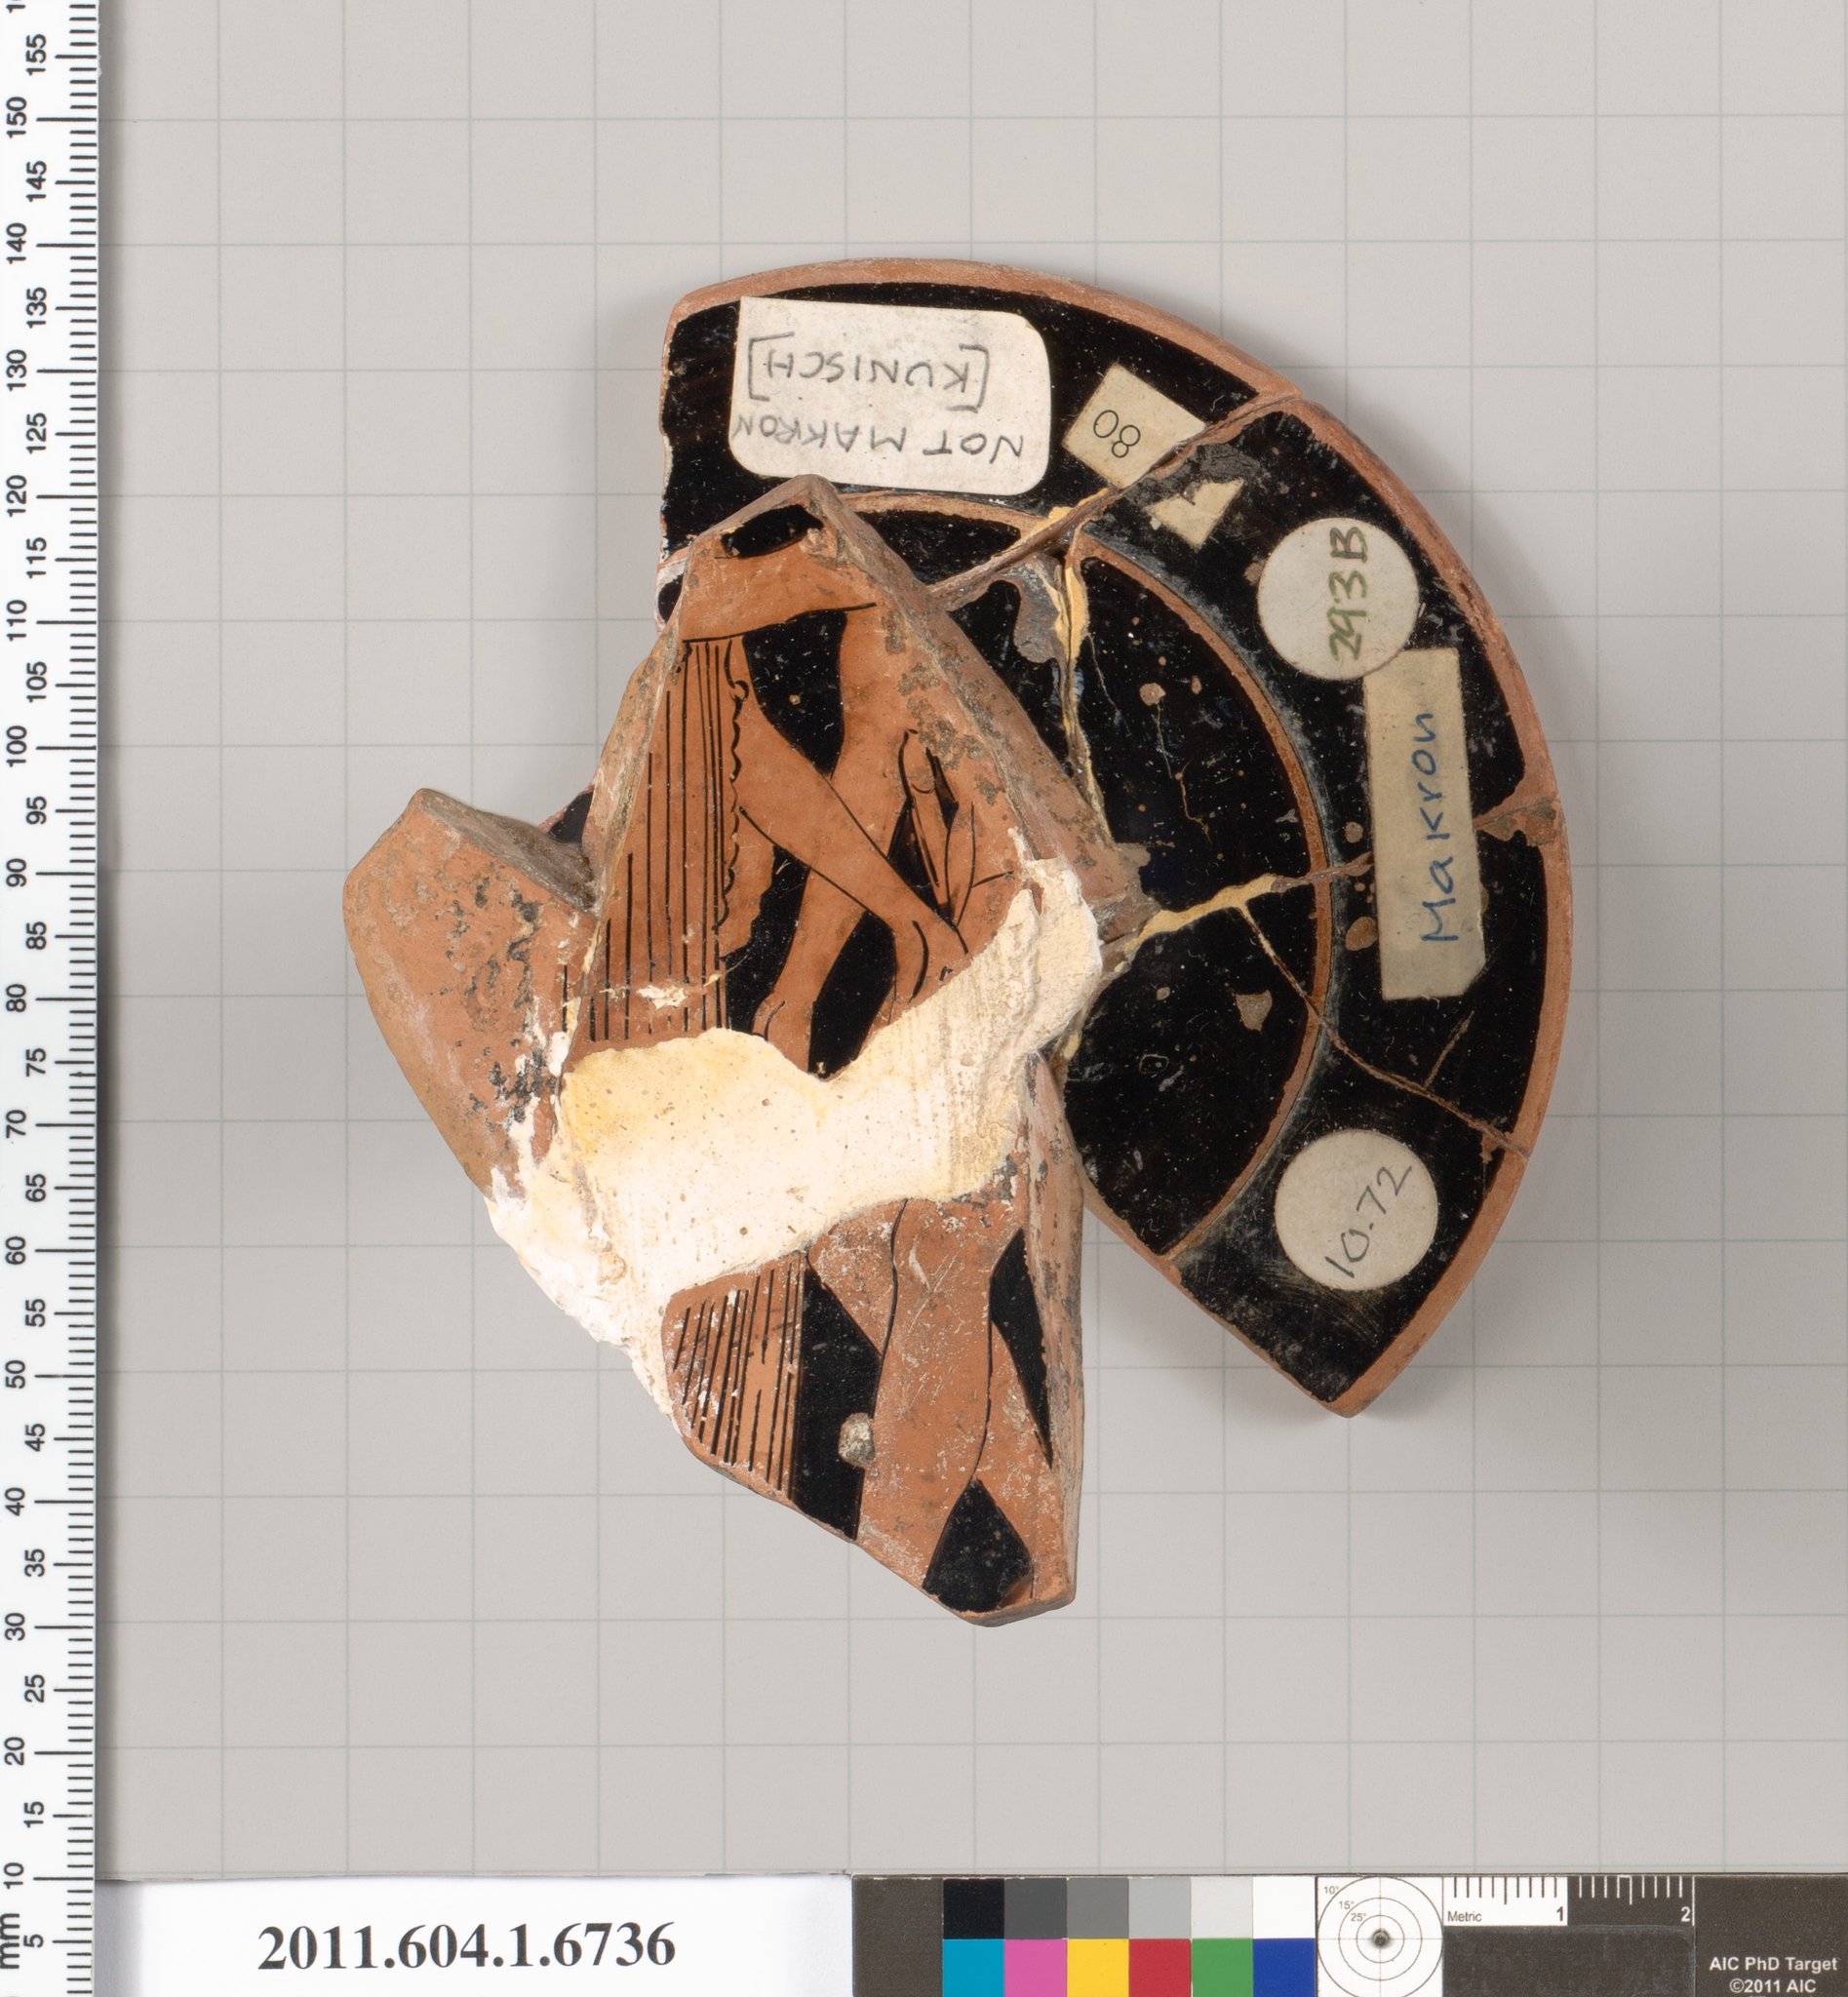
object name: kylix fragment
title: Terracotta fragment of a kylix (drinking cup)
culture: greek, attic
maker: makron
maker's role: artist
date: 490-470 BCE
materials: terracotta